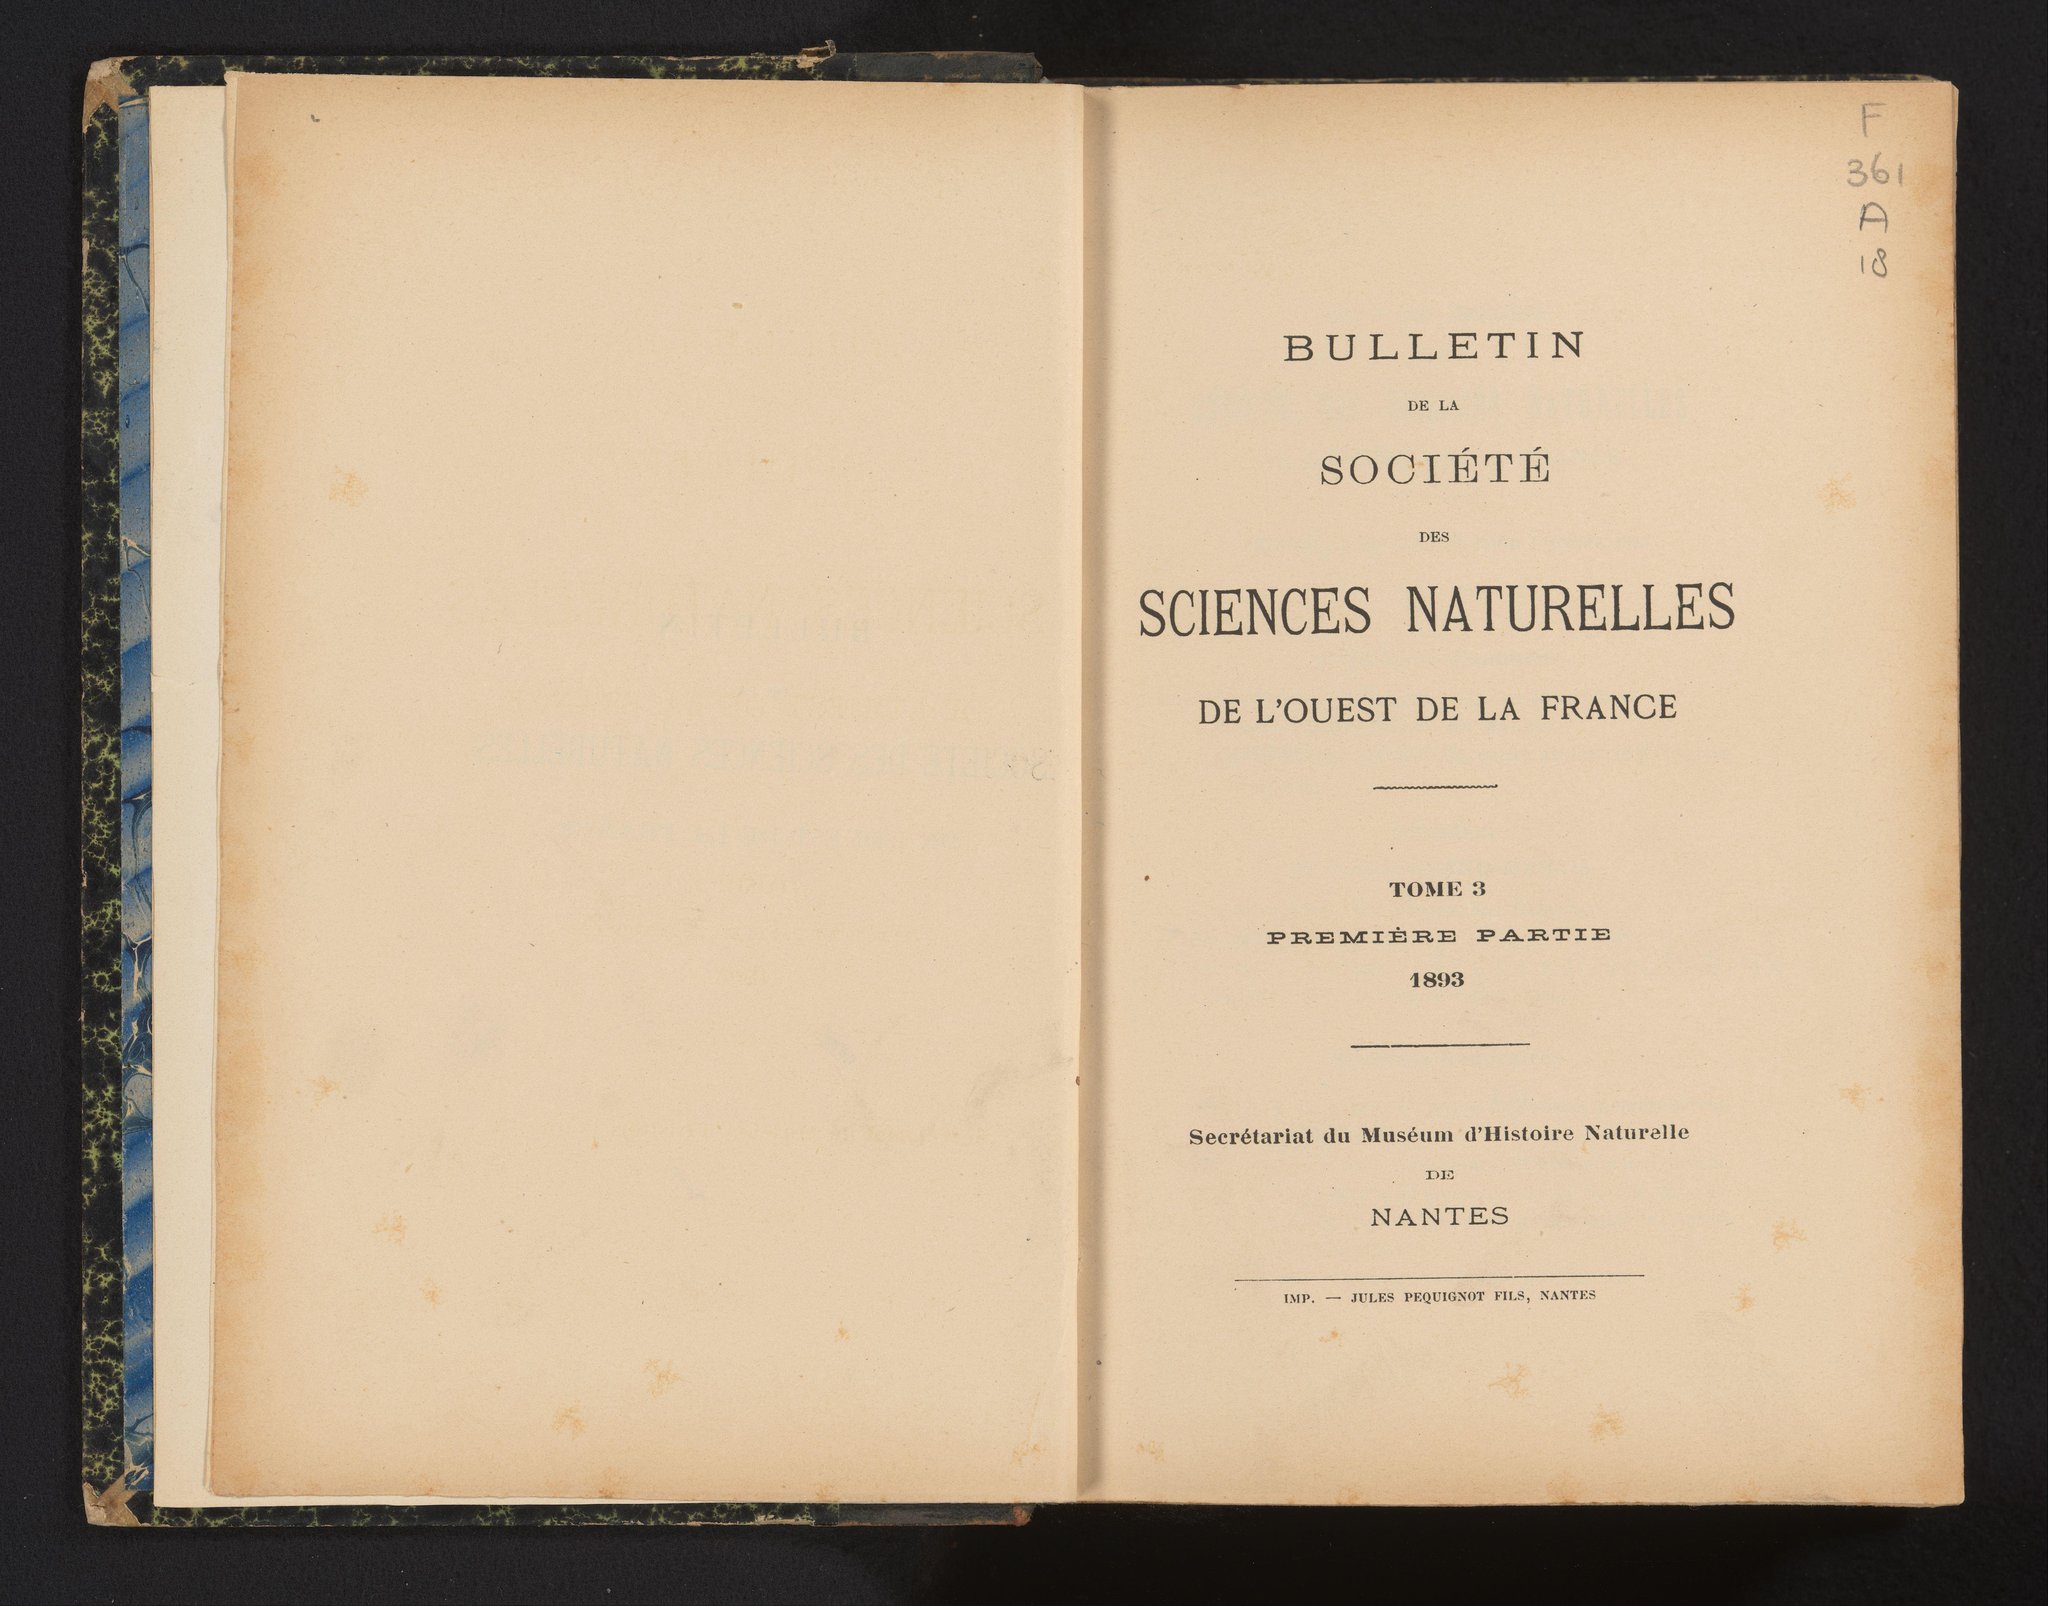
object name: book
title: Bulletin de la Société des sciences naturelles de l'ouest de la France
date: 1893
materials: cardboard, leather, linen, paper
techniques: marbled paper, photograph, lithograph, printing, engraving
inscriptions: date: ‘JAN/ 1998’